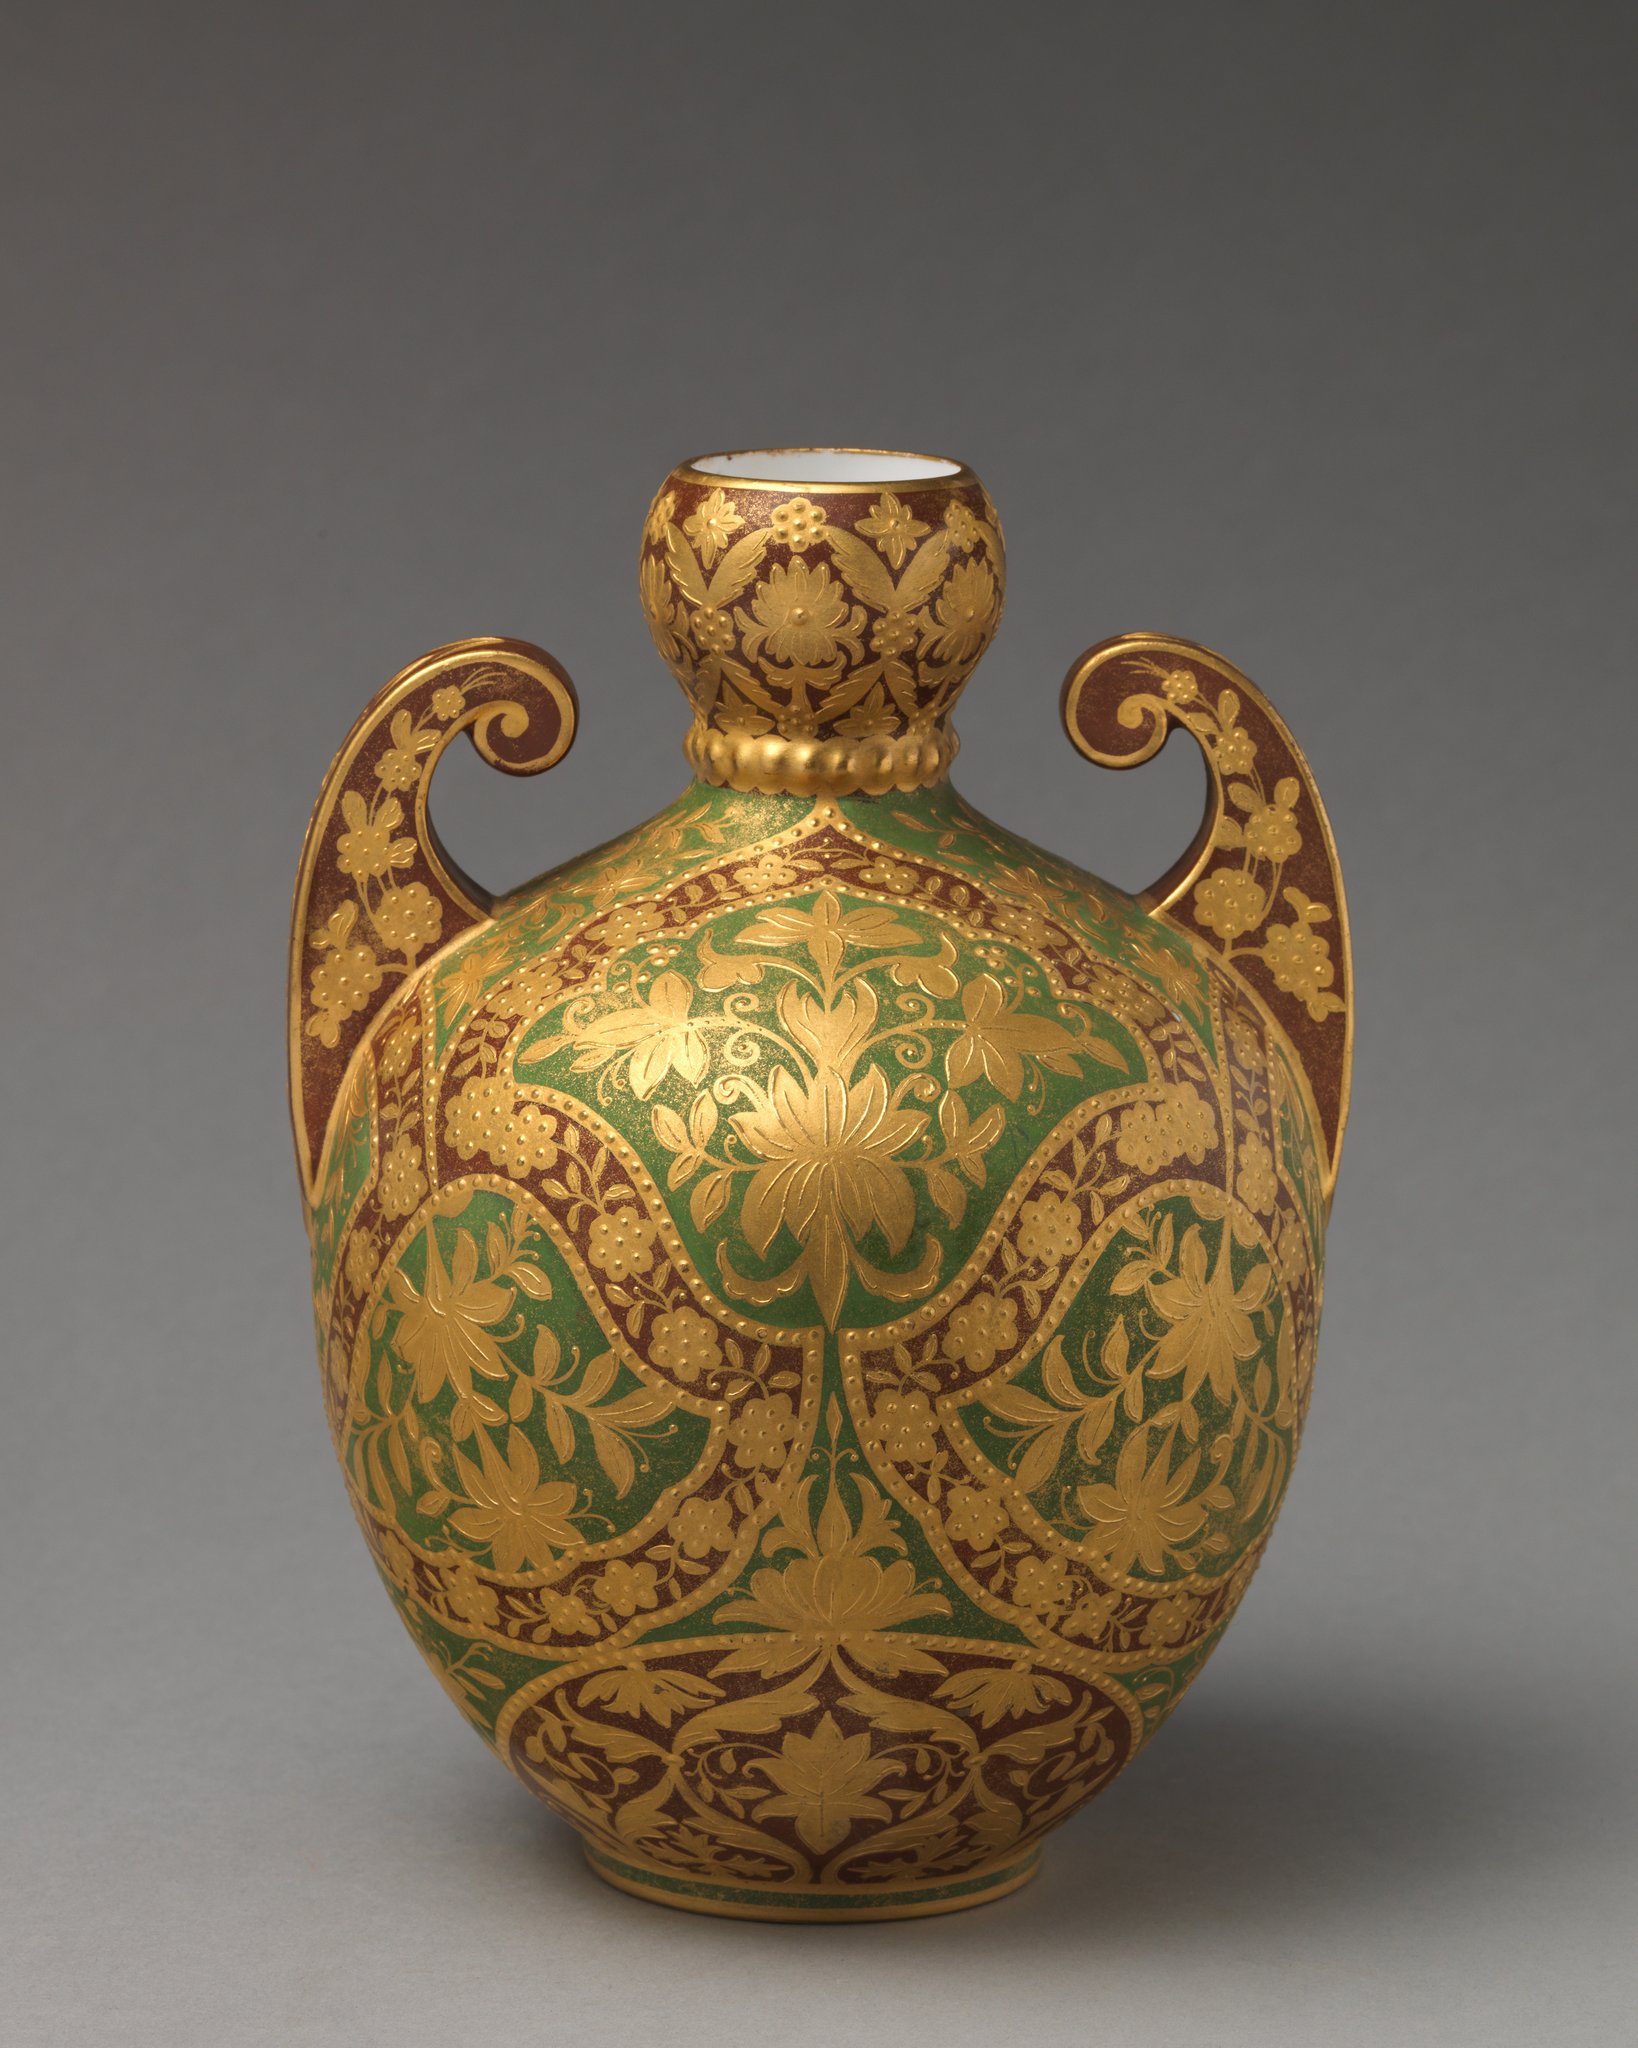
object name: vase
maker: crown derby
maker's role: maker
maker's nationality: british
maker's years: 1750-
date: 1884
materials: porcelain